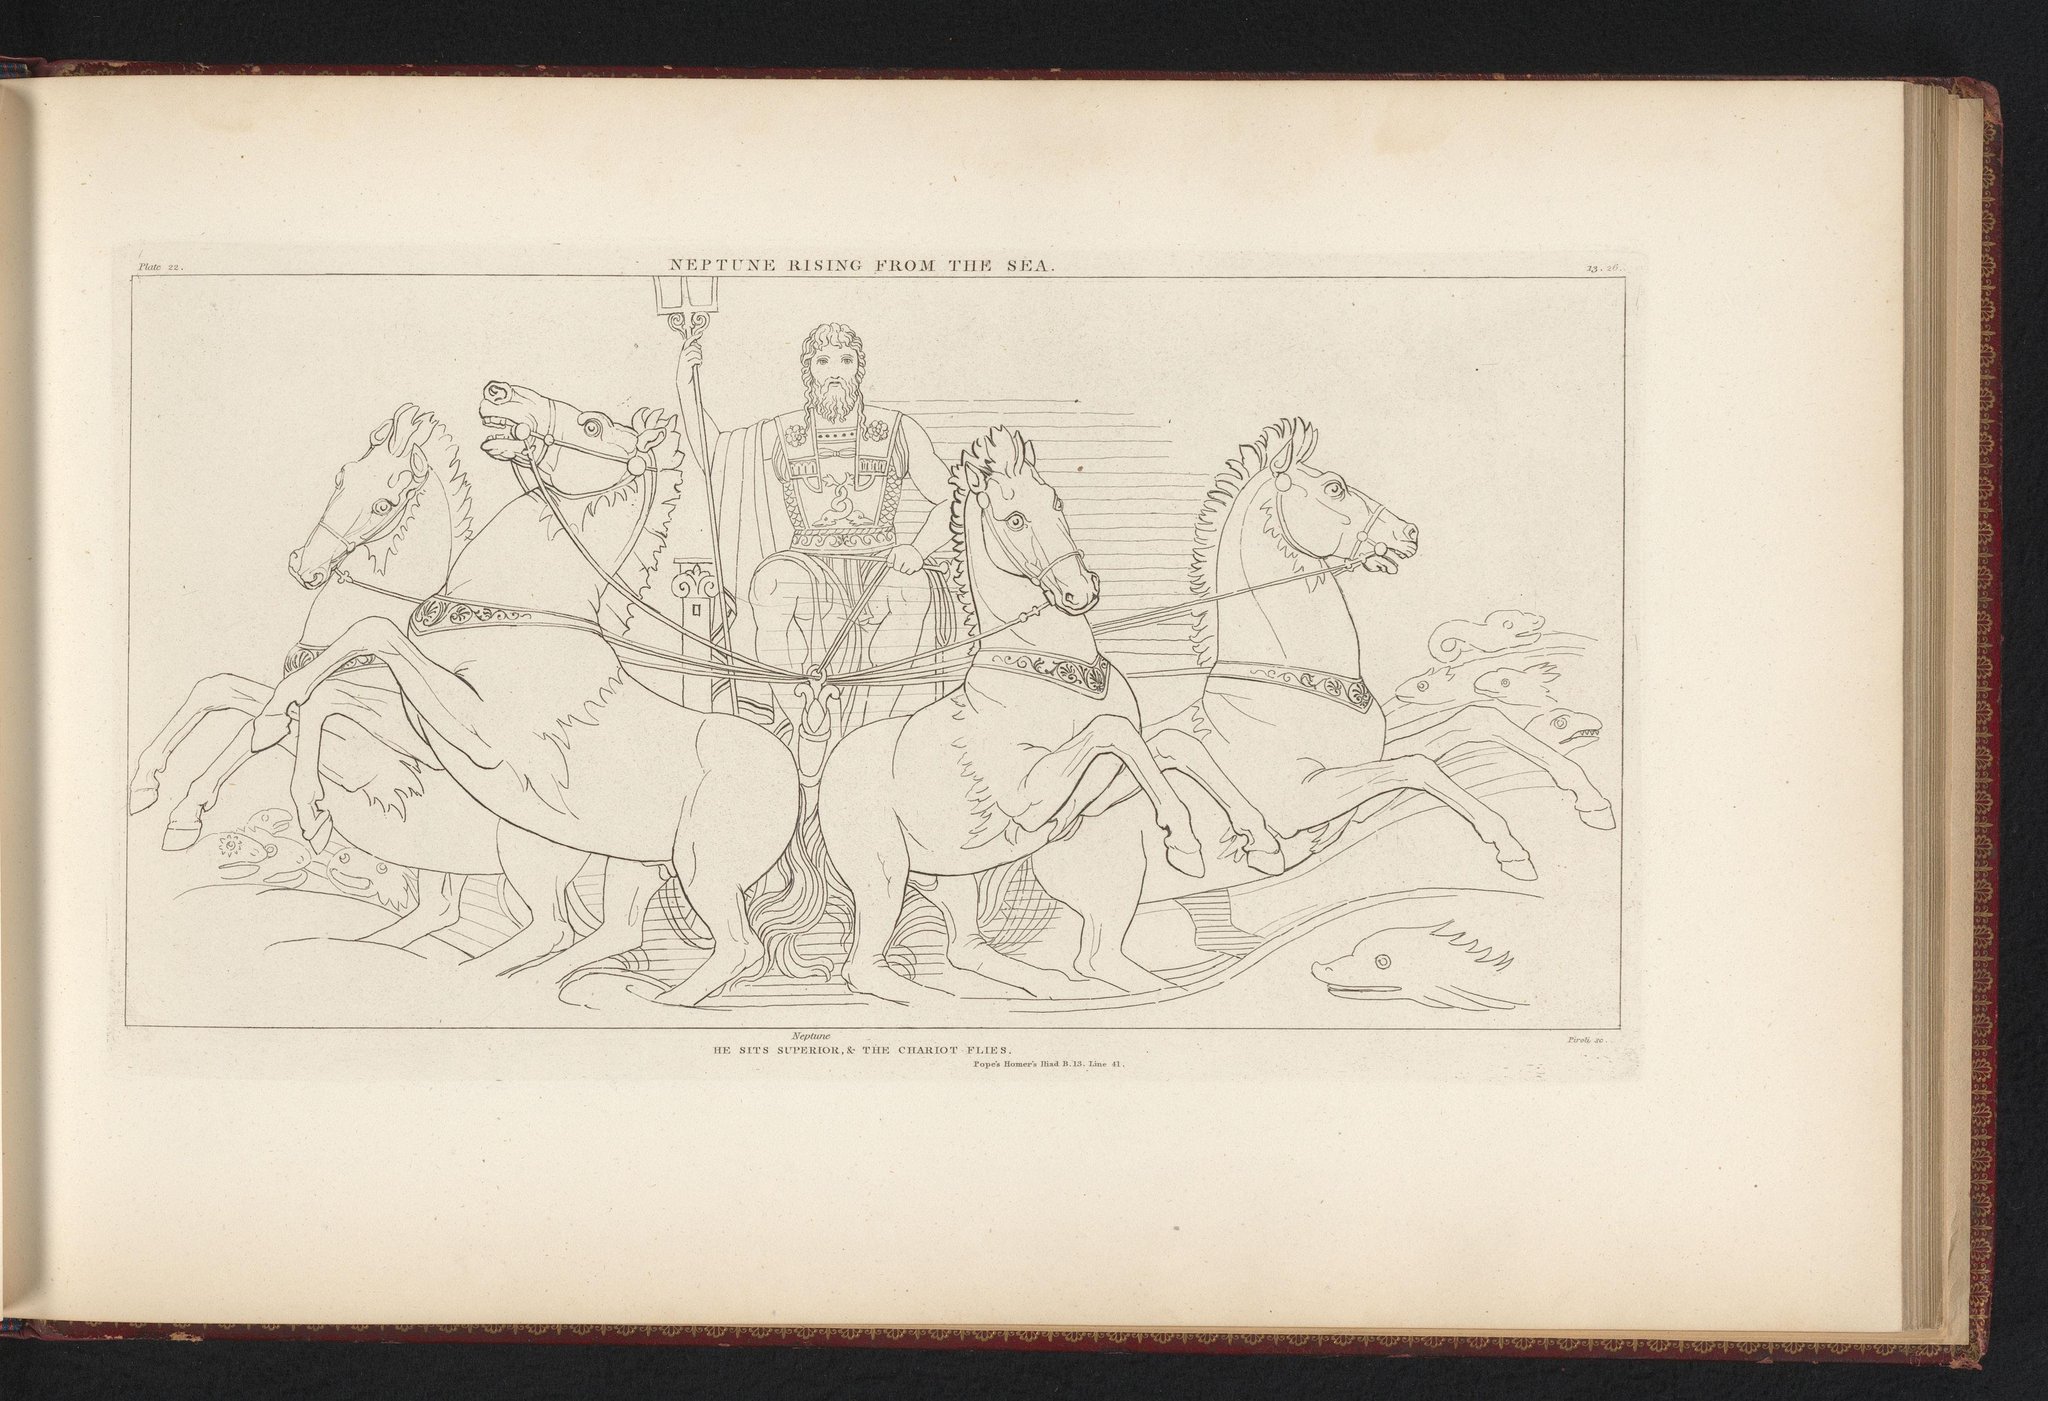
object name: album leaf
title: Iliad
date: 1805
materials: paper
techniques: etching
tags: (story of) neptune (poseidon)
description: Prent maakt onderdeel uit van een serie met 39 prenten over de Ilias, geschreven door Homerus.